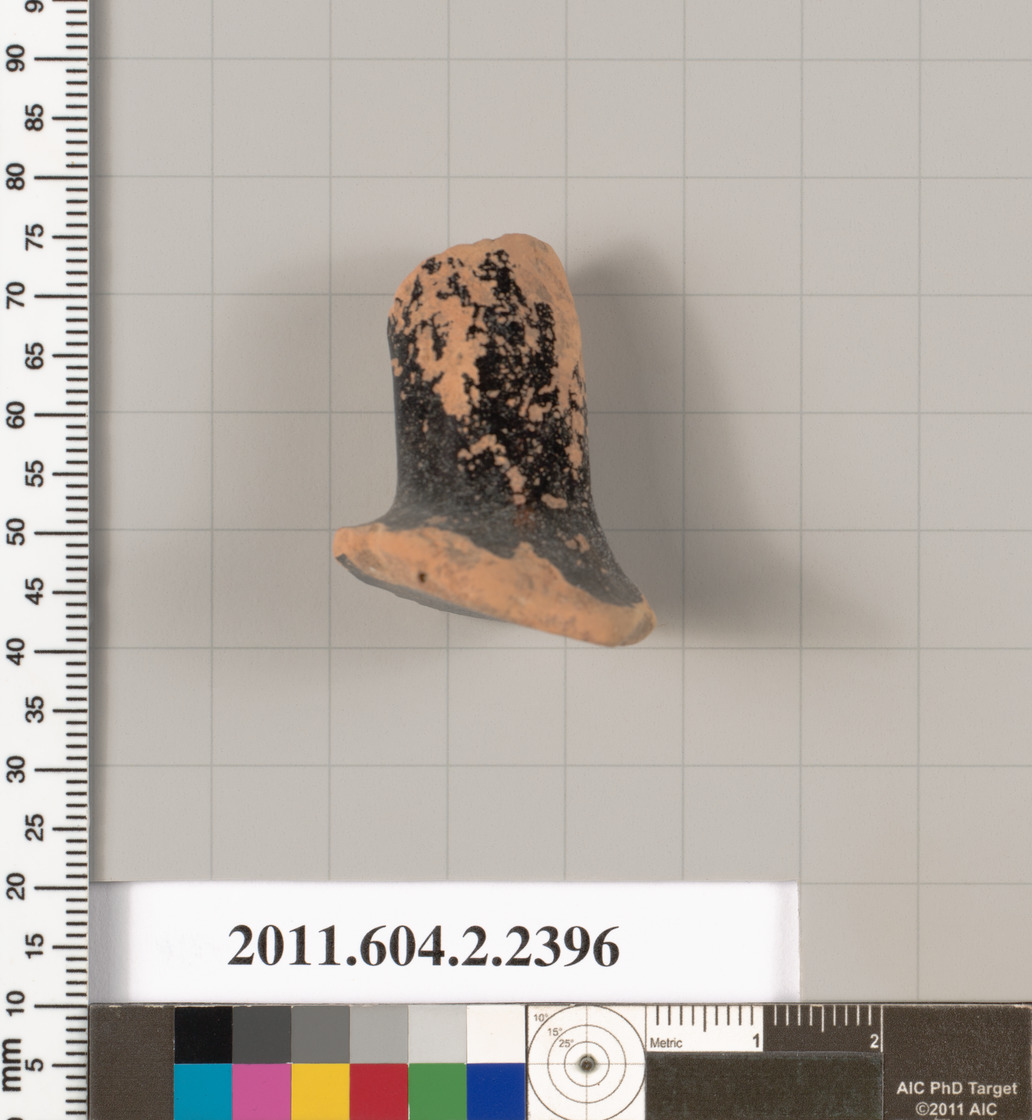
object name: skyphos fragment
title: Terracotta fragment of a skyphos (deep drinking cup)?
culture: greek, attic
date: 600-401 BCE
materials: terracotta